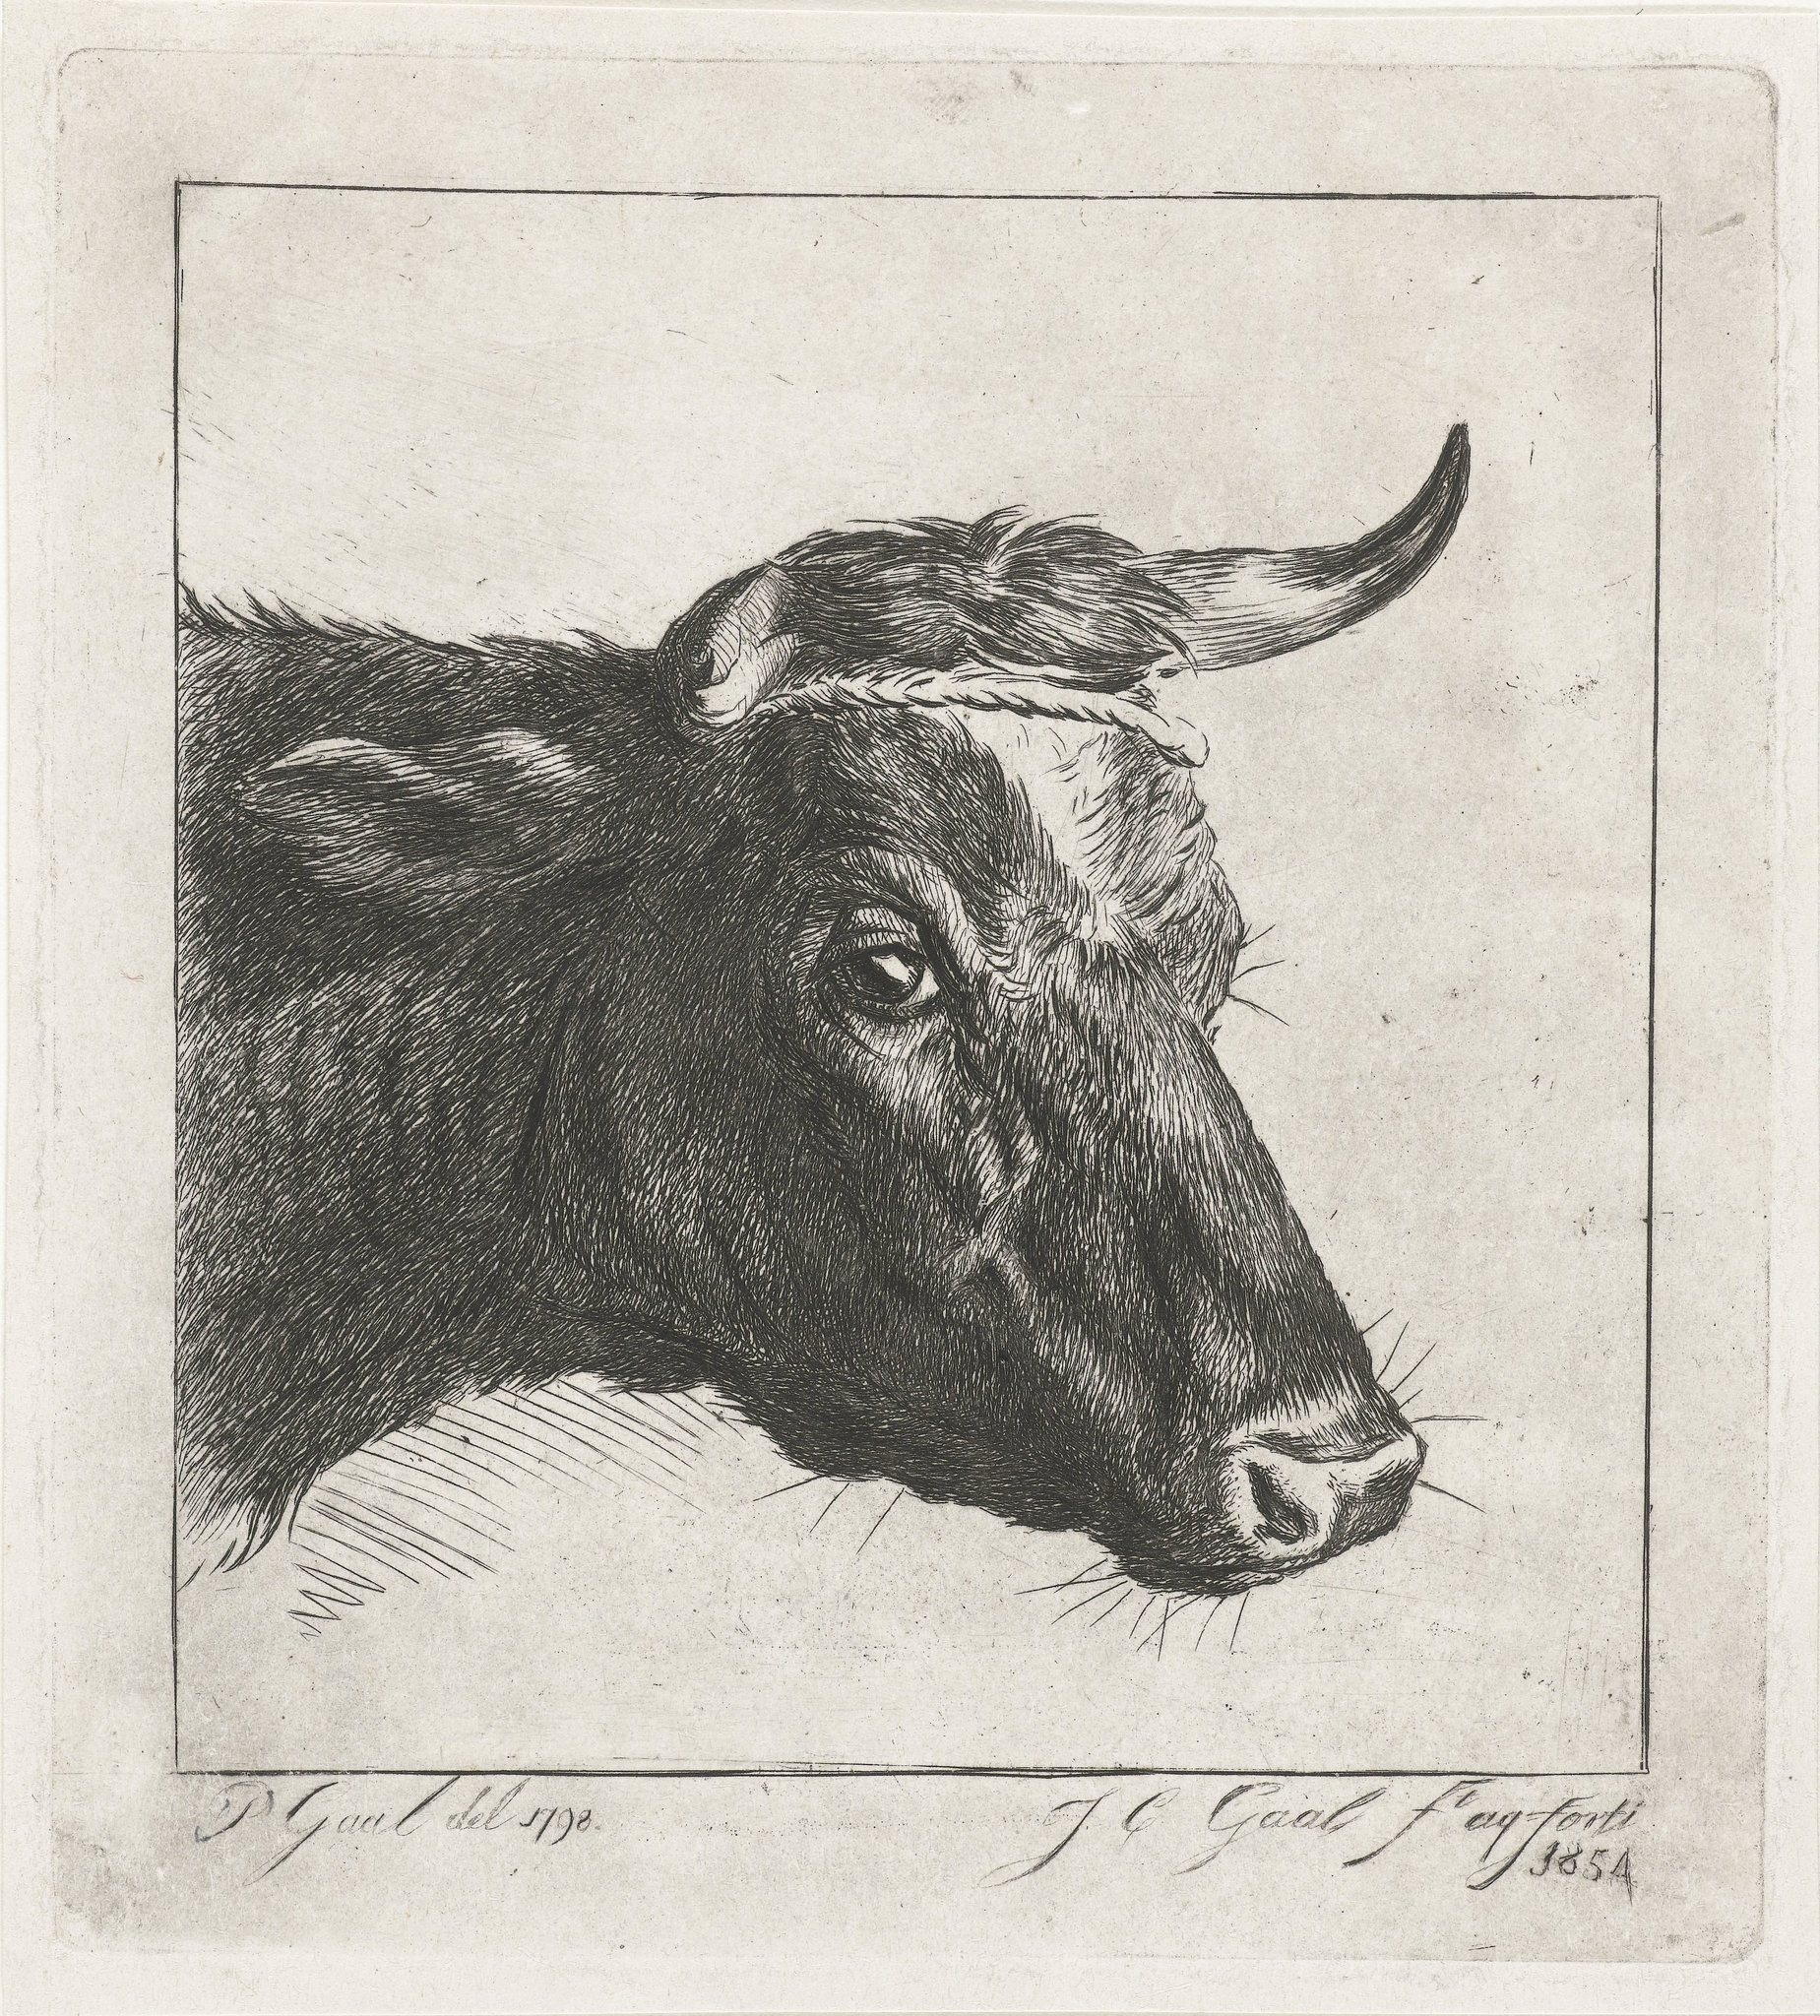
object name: print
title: Kop van een koe met touw om de horens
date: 1854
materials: paper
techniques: etching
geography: netherlands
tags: cow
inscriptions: collector's mark: Lugt 2228